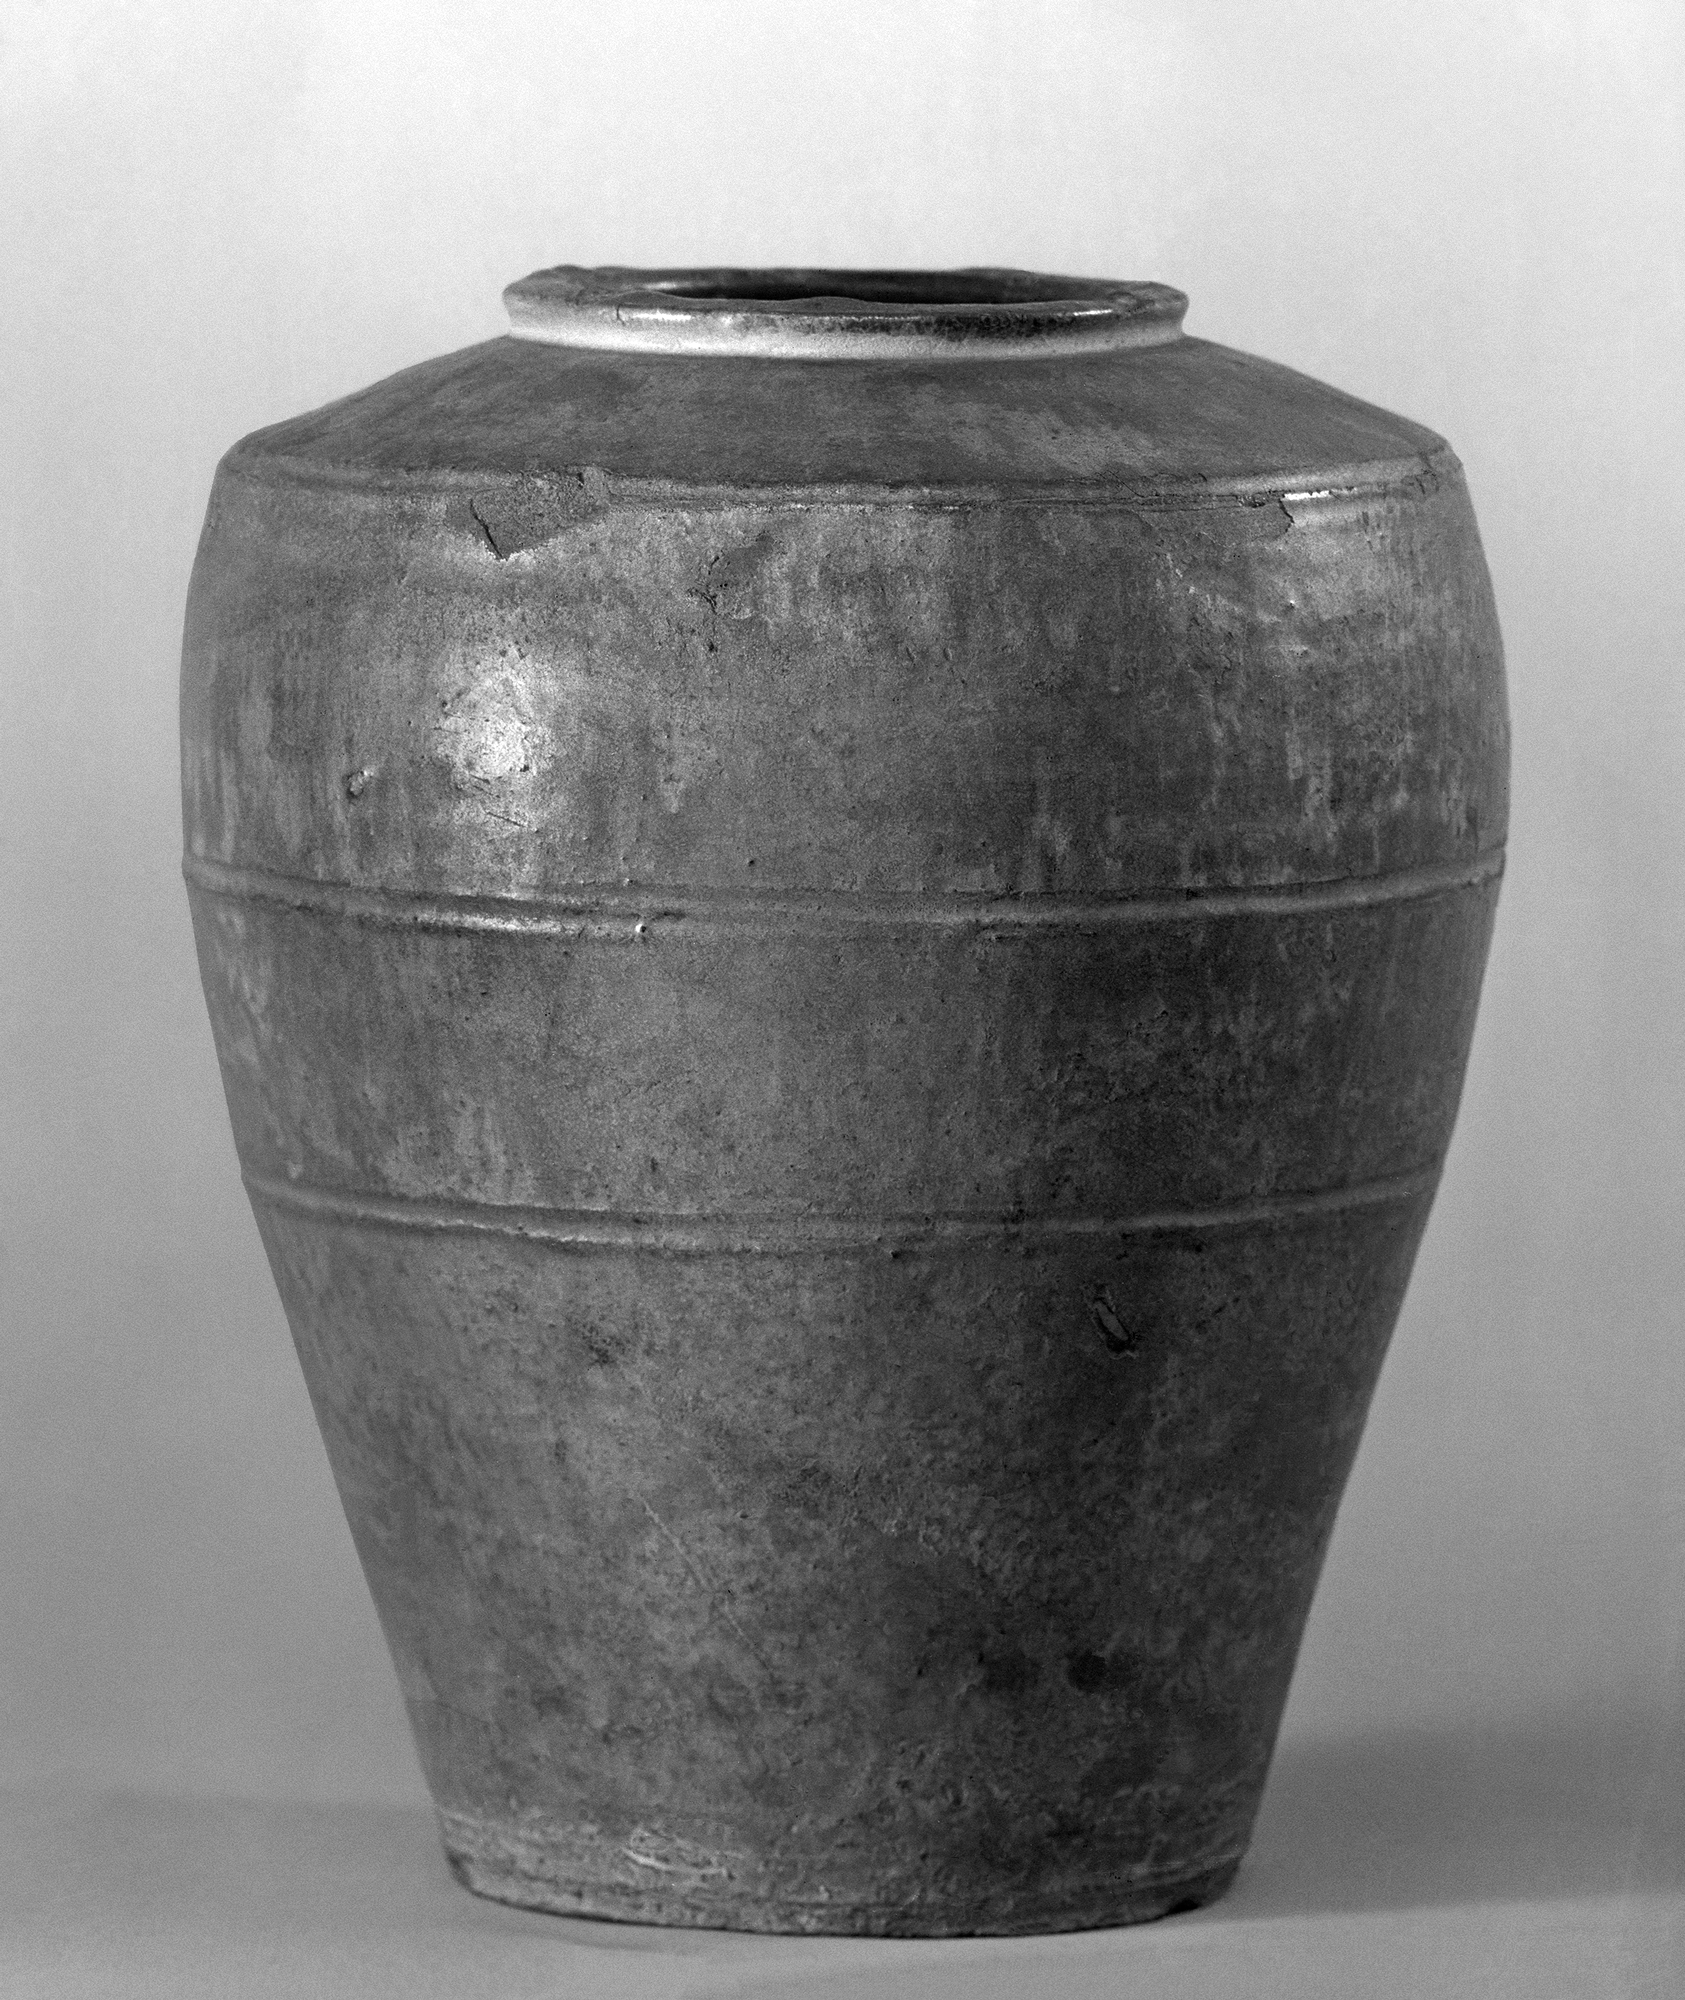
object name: urn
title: Granary urn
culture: chinese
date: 1-200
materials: earthenware, glaze, lead